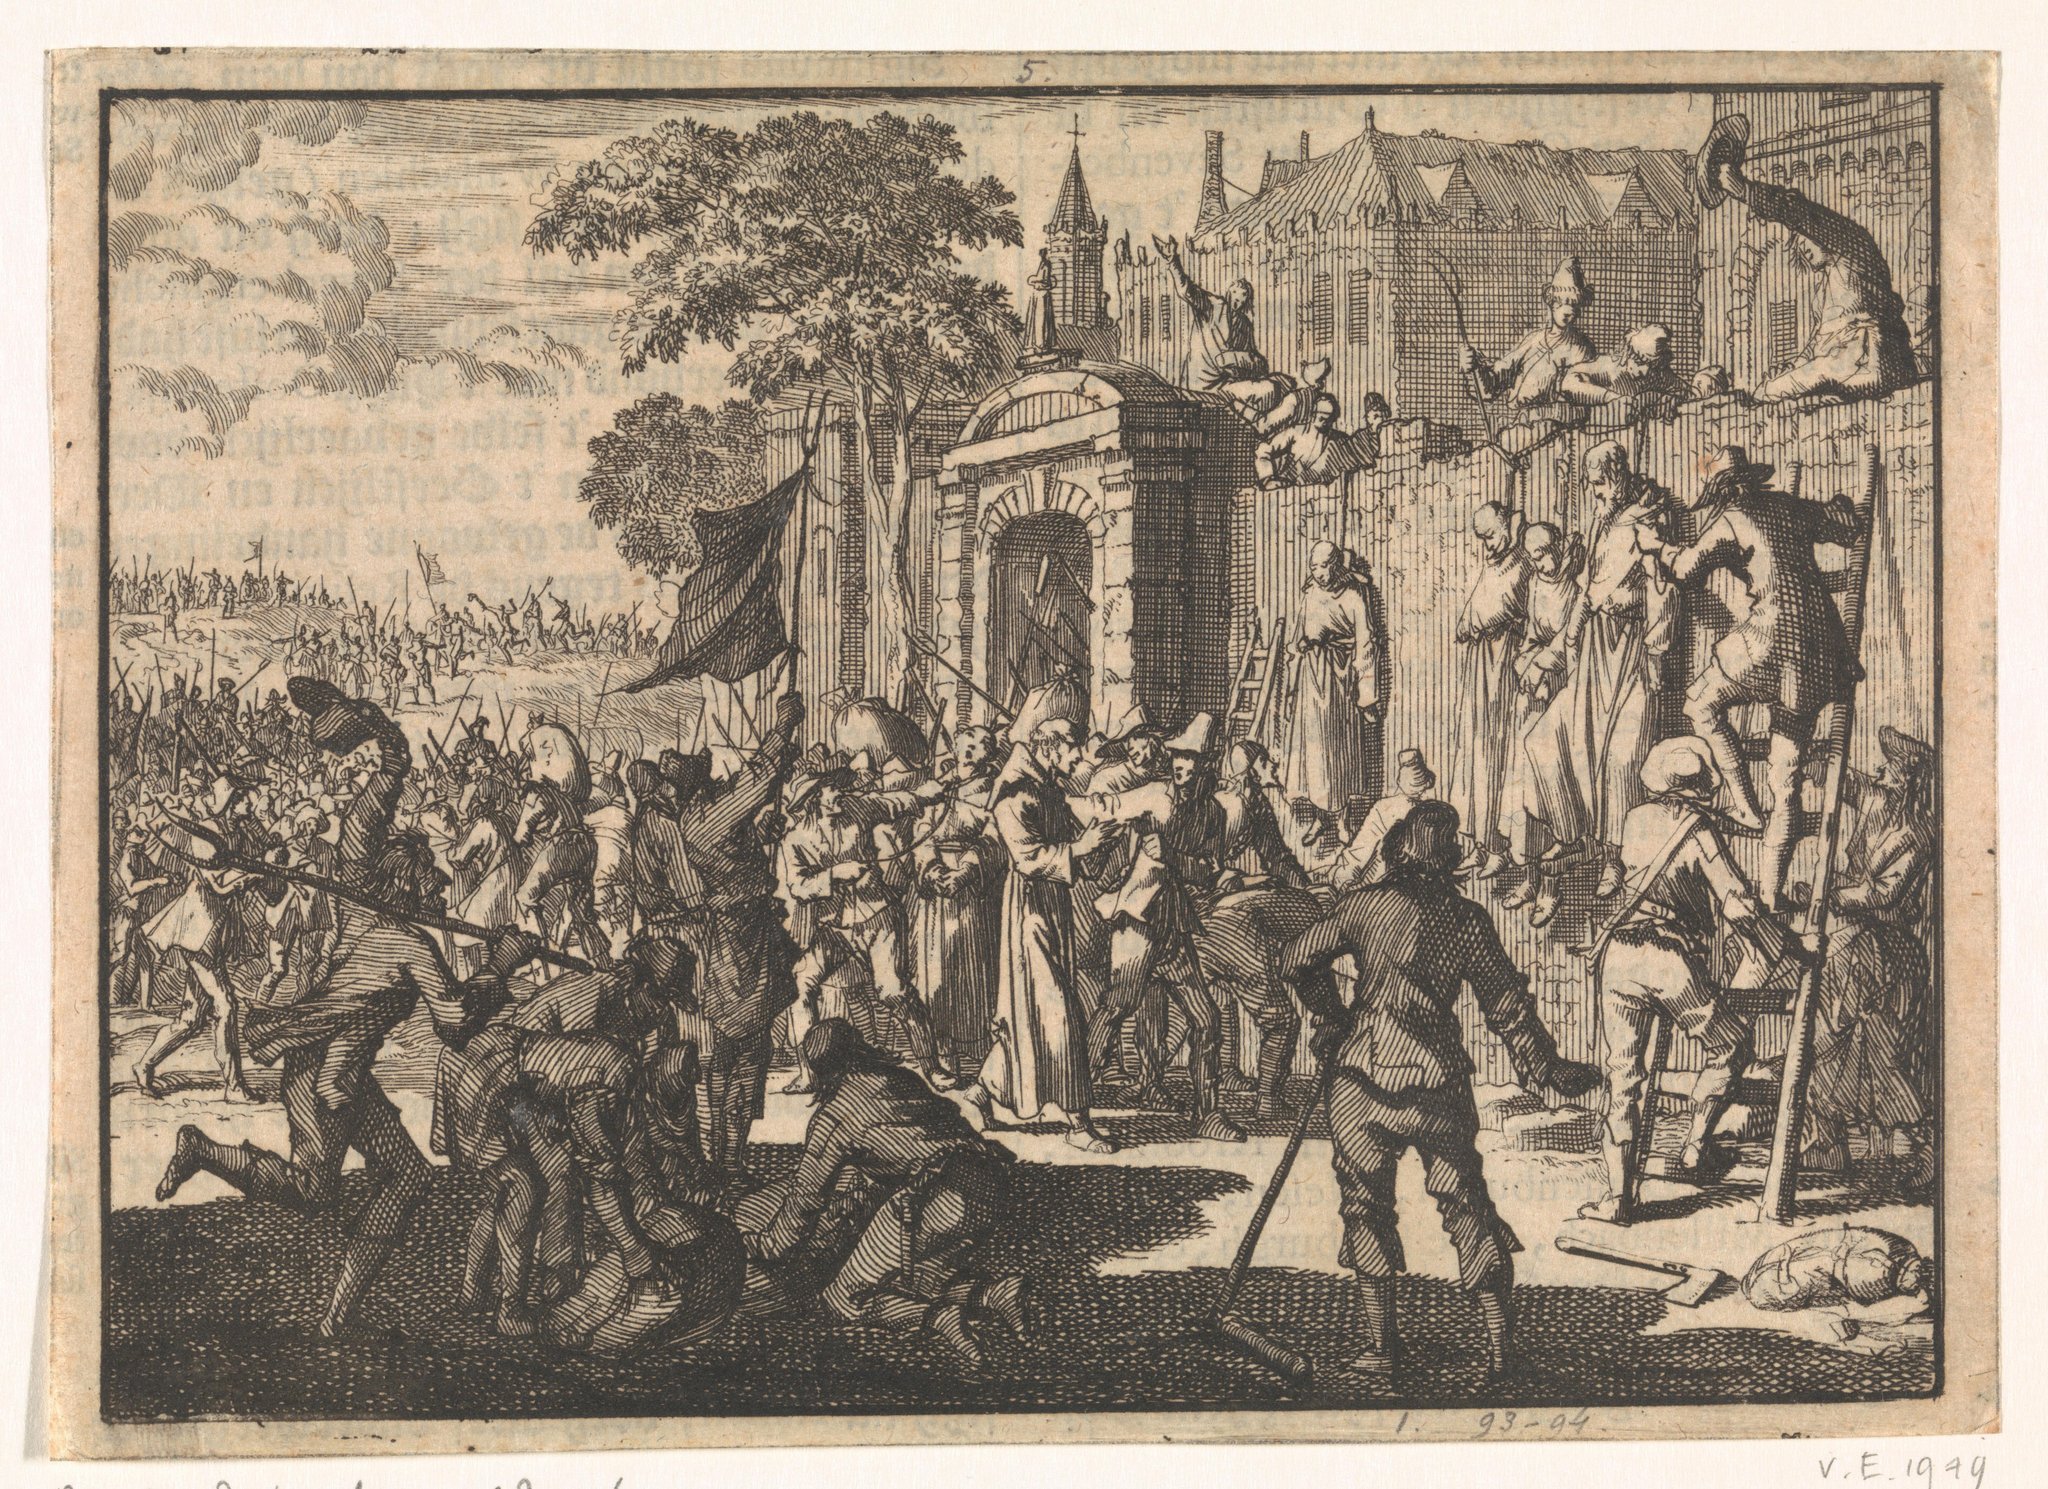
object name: print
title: Monniken uit een klooster nabij Linz worden in de Boerenoorlog aan de muren van hun klooster opgehangen, 1596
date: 1698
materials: paper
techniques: etching, letterpress printing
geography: leiden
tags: violent death by hanging, monk(s), friar(s), cloisters ~ monastery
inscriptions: collector's mark: Lugt 2228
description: Illustratie uit: Gottfried, Johann Ludwig. Historische kronyck; vervattende een (...) beschrijvingh der aldergedenckwaerdigste geschiedenissen des weerelds, van den aenvangh der scheppingh tot (...) 1576 (2 delen). Leiden: Pieter van der Aa, 1698, dl. I, p. 93.